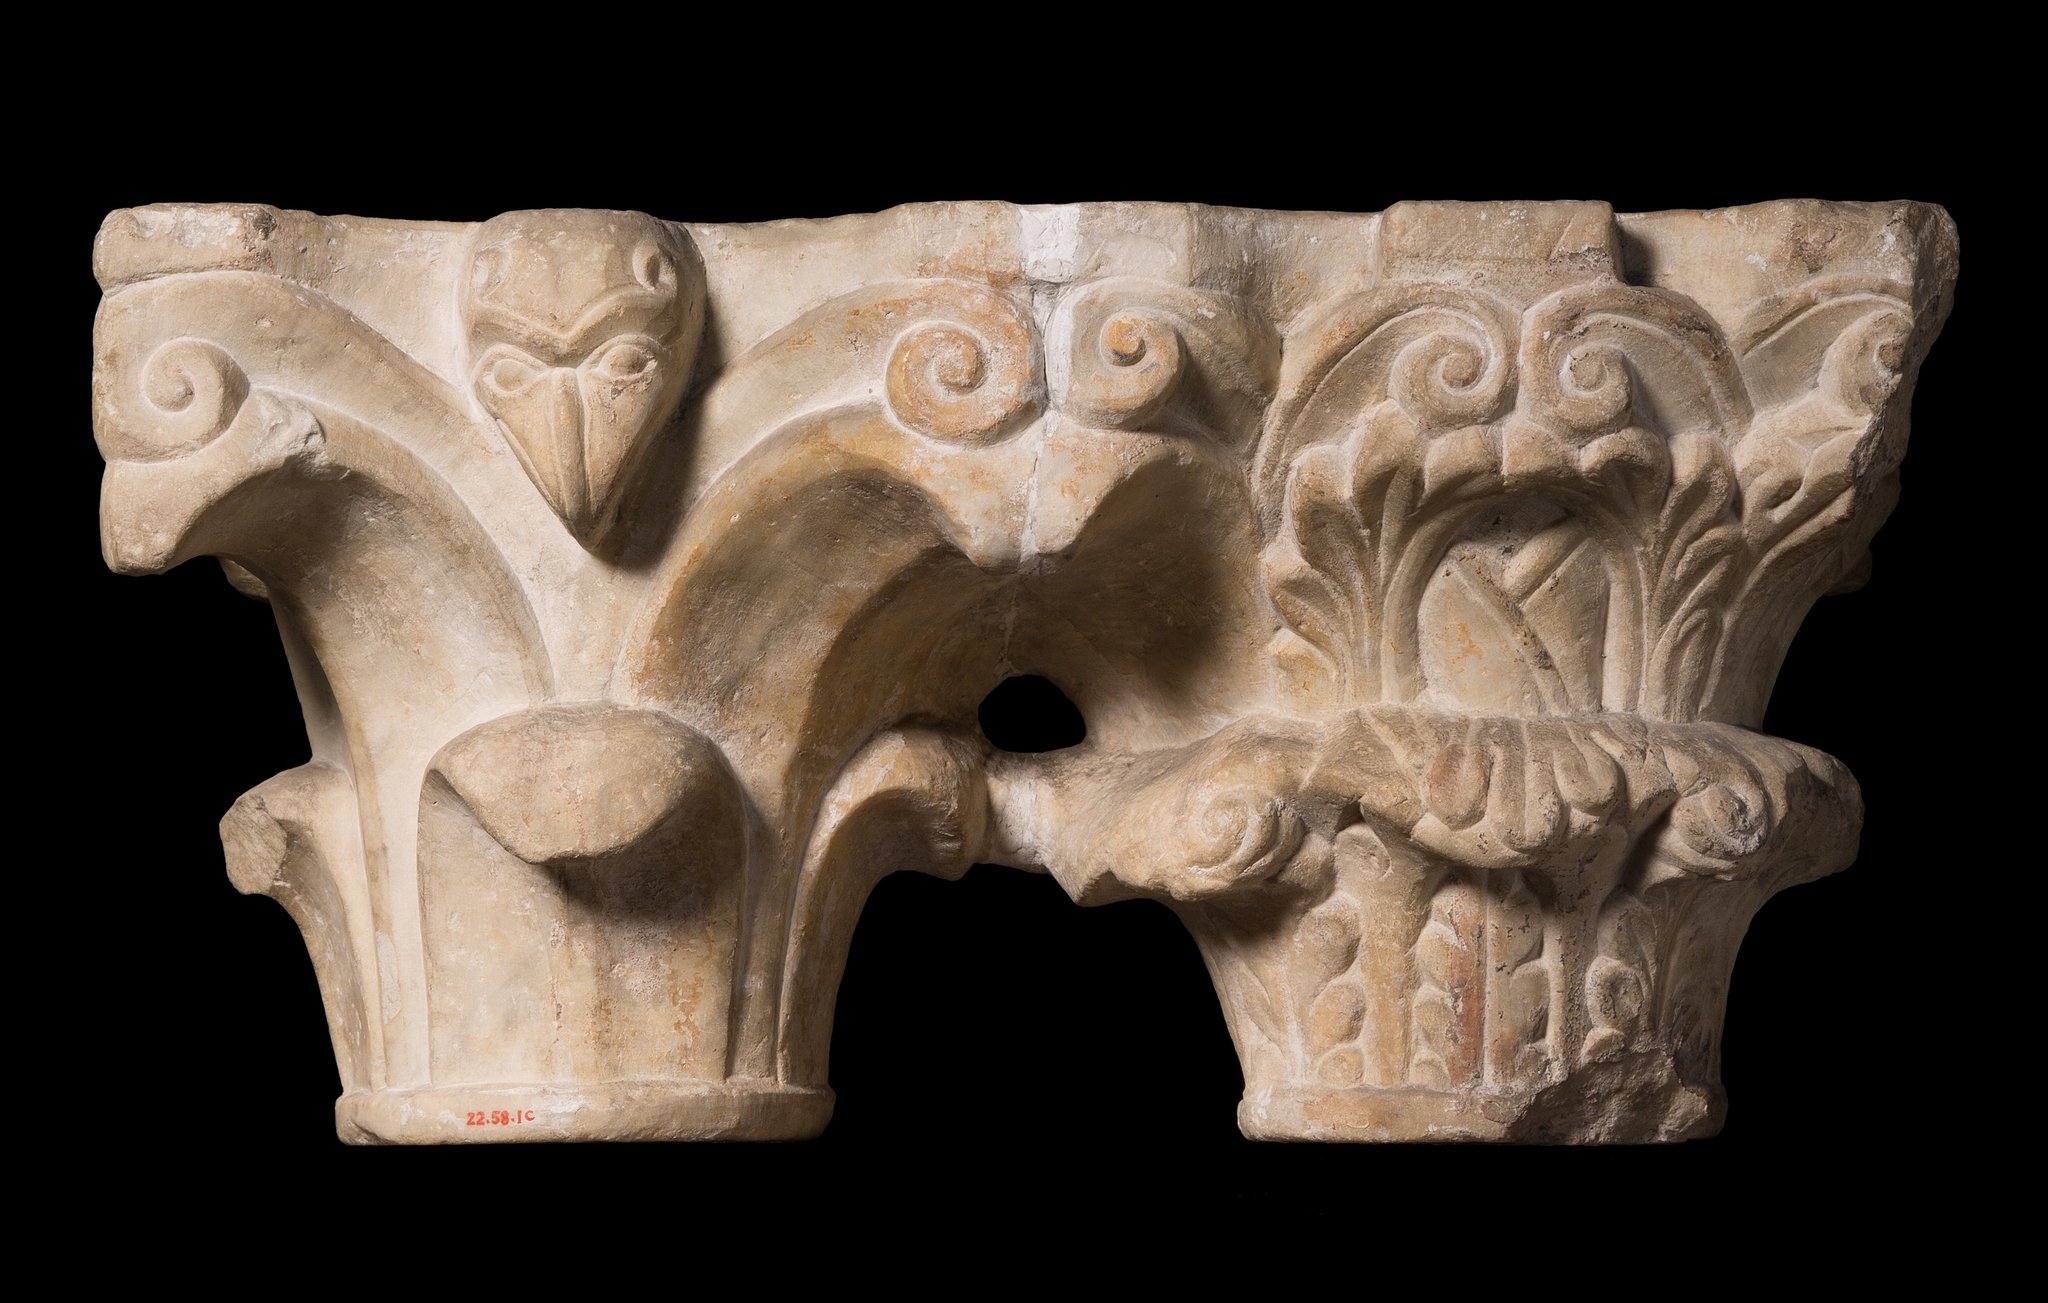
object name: capital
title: Double Capital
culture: french or italian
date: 1001-1300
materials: marble